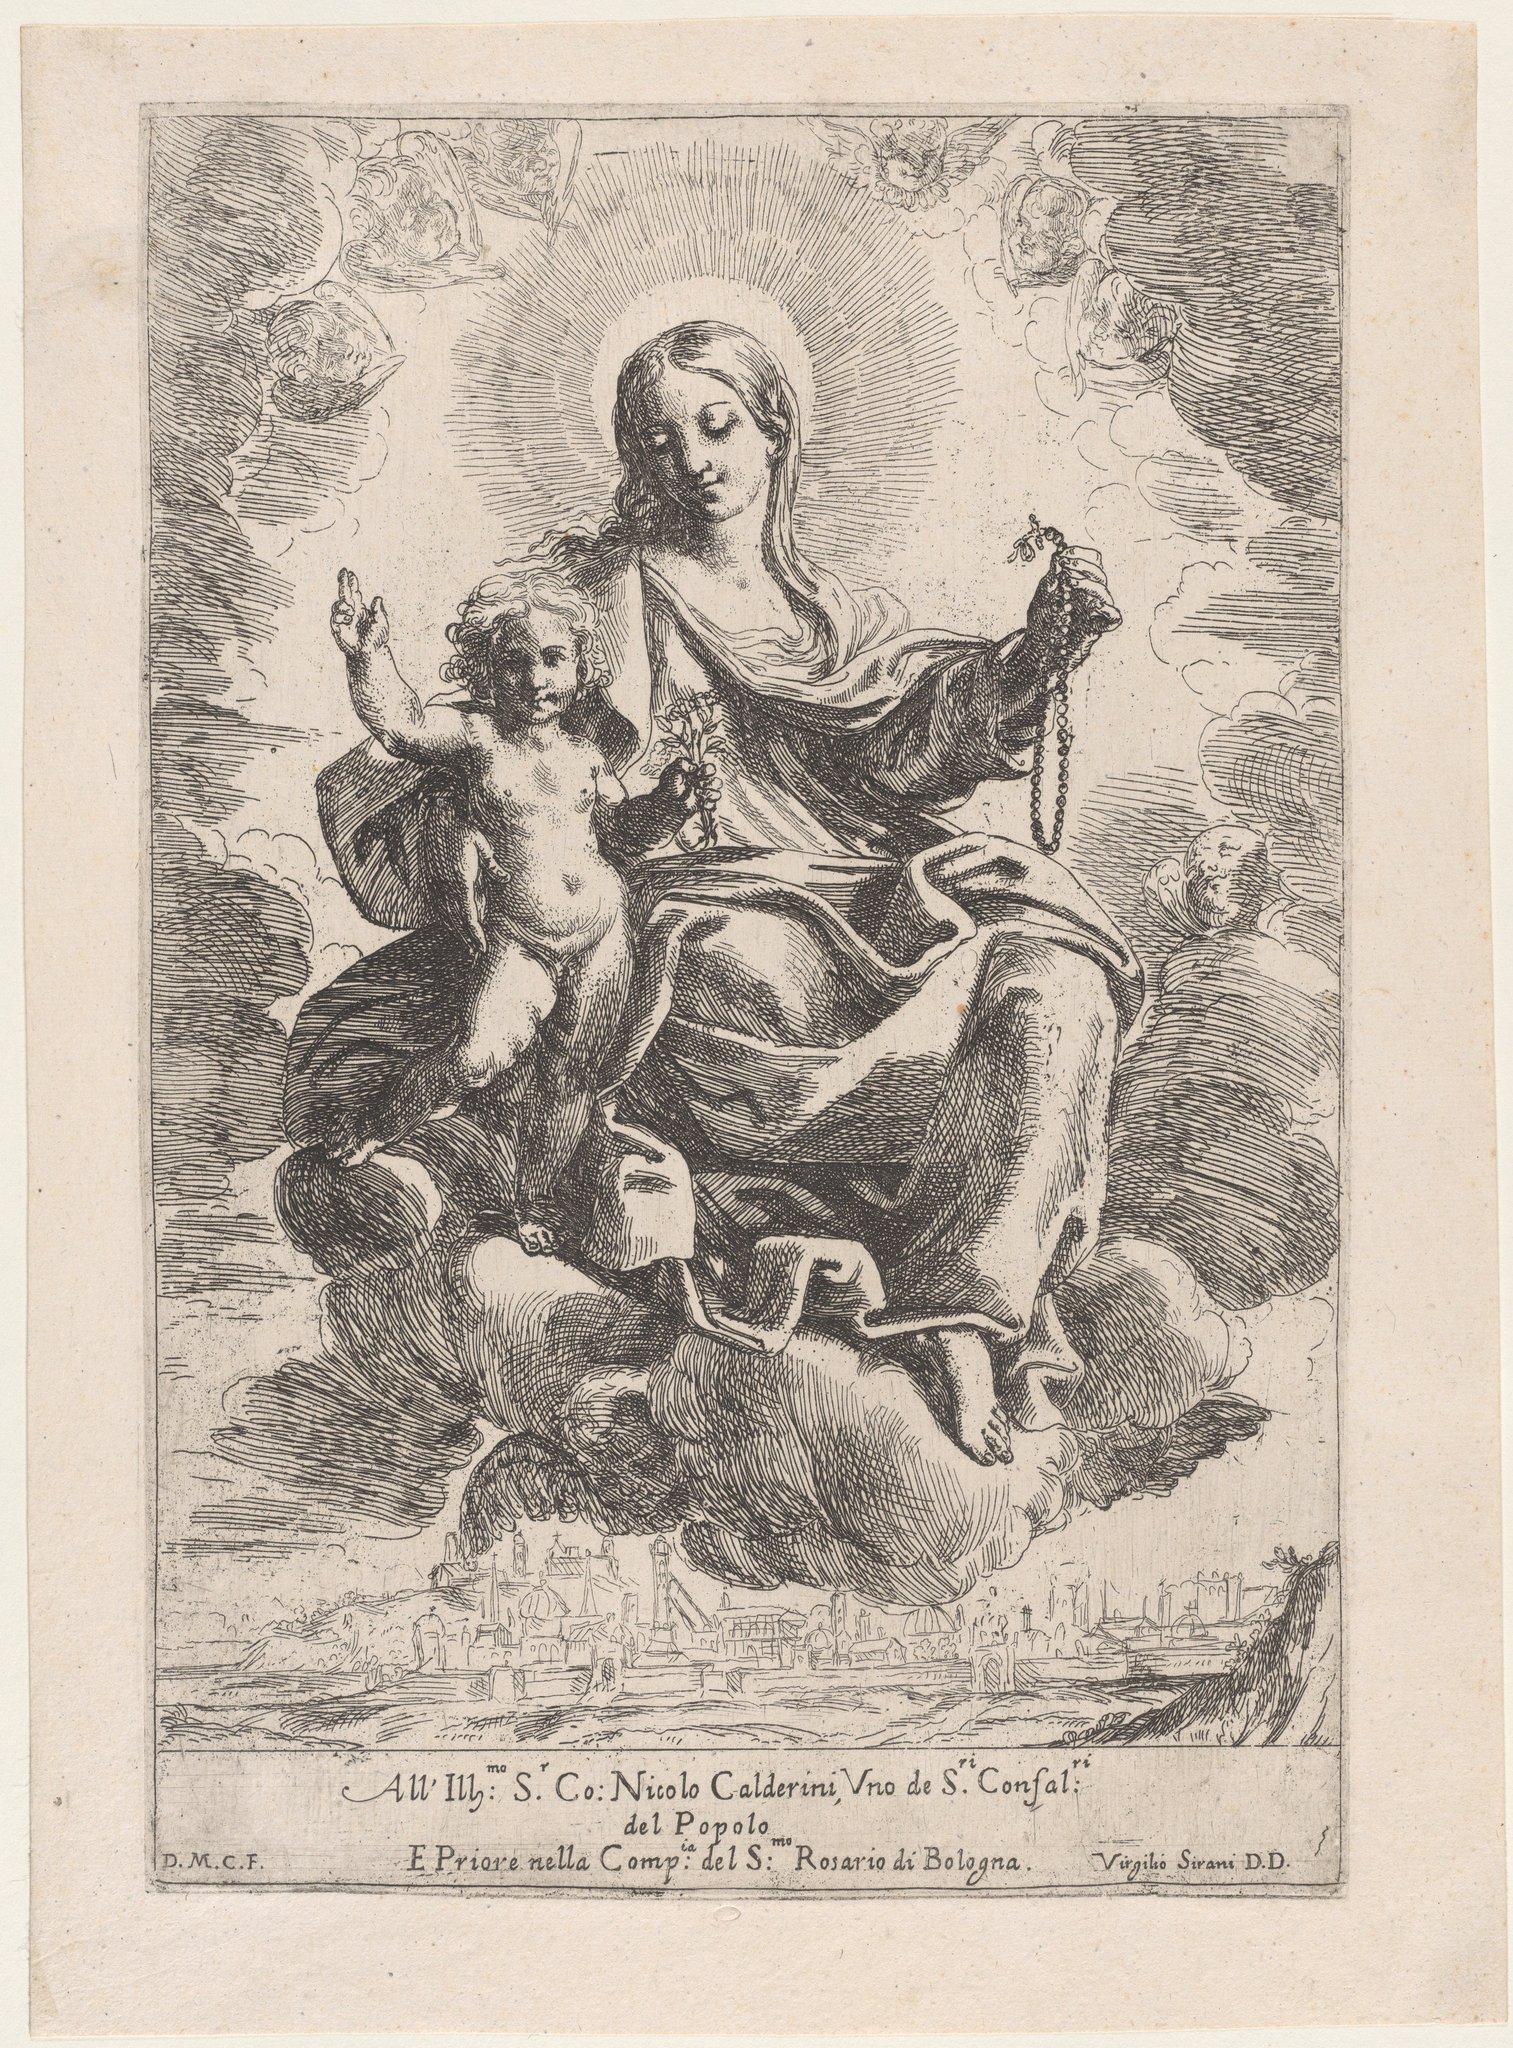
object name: print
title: The Virgin of the Rosary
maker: domenico maria canuti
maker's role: artist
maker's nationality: italian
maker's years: 1625-1684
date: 1645-1684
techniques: etching